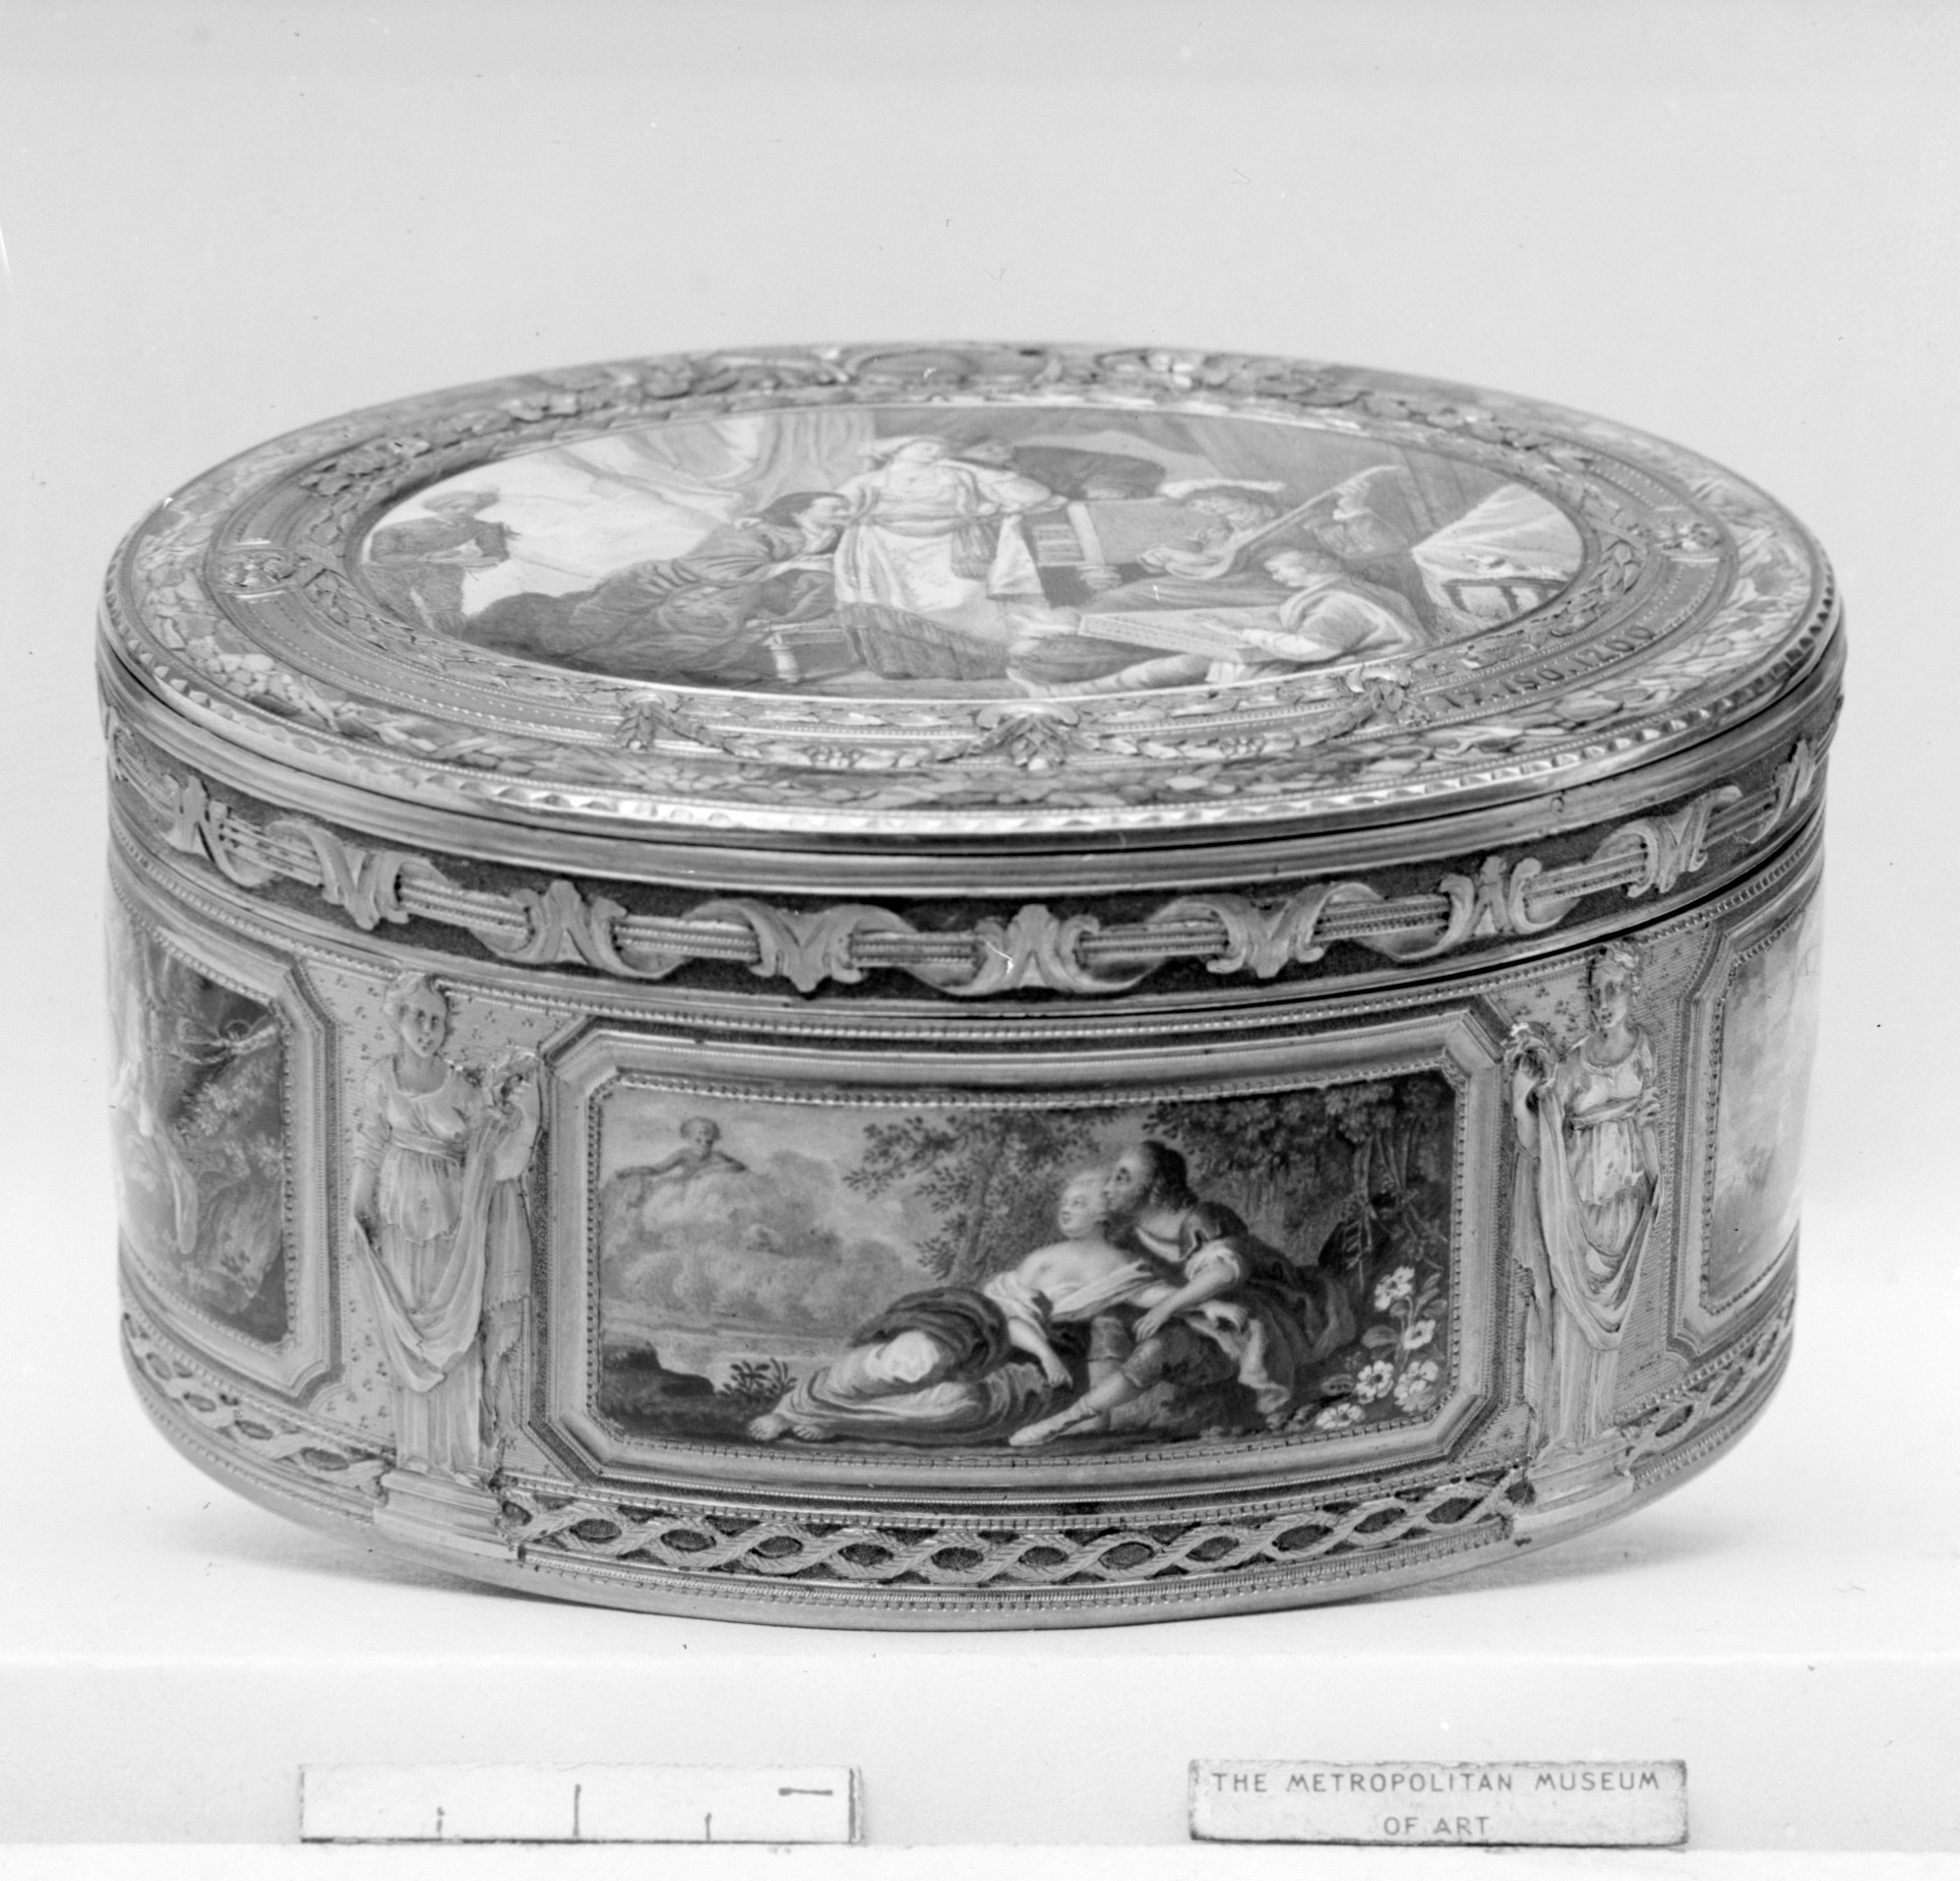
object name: snuffbox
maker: louis-philippe demay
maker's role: maker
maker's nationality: french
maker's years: 1672-1772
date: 1766-1767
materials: enamel, gold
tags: men,women,flowers,trees